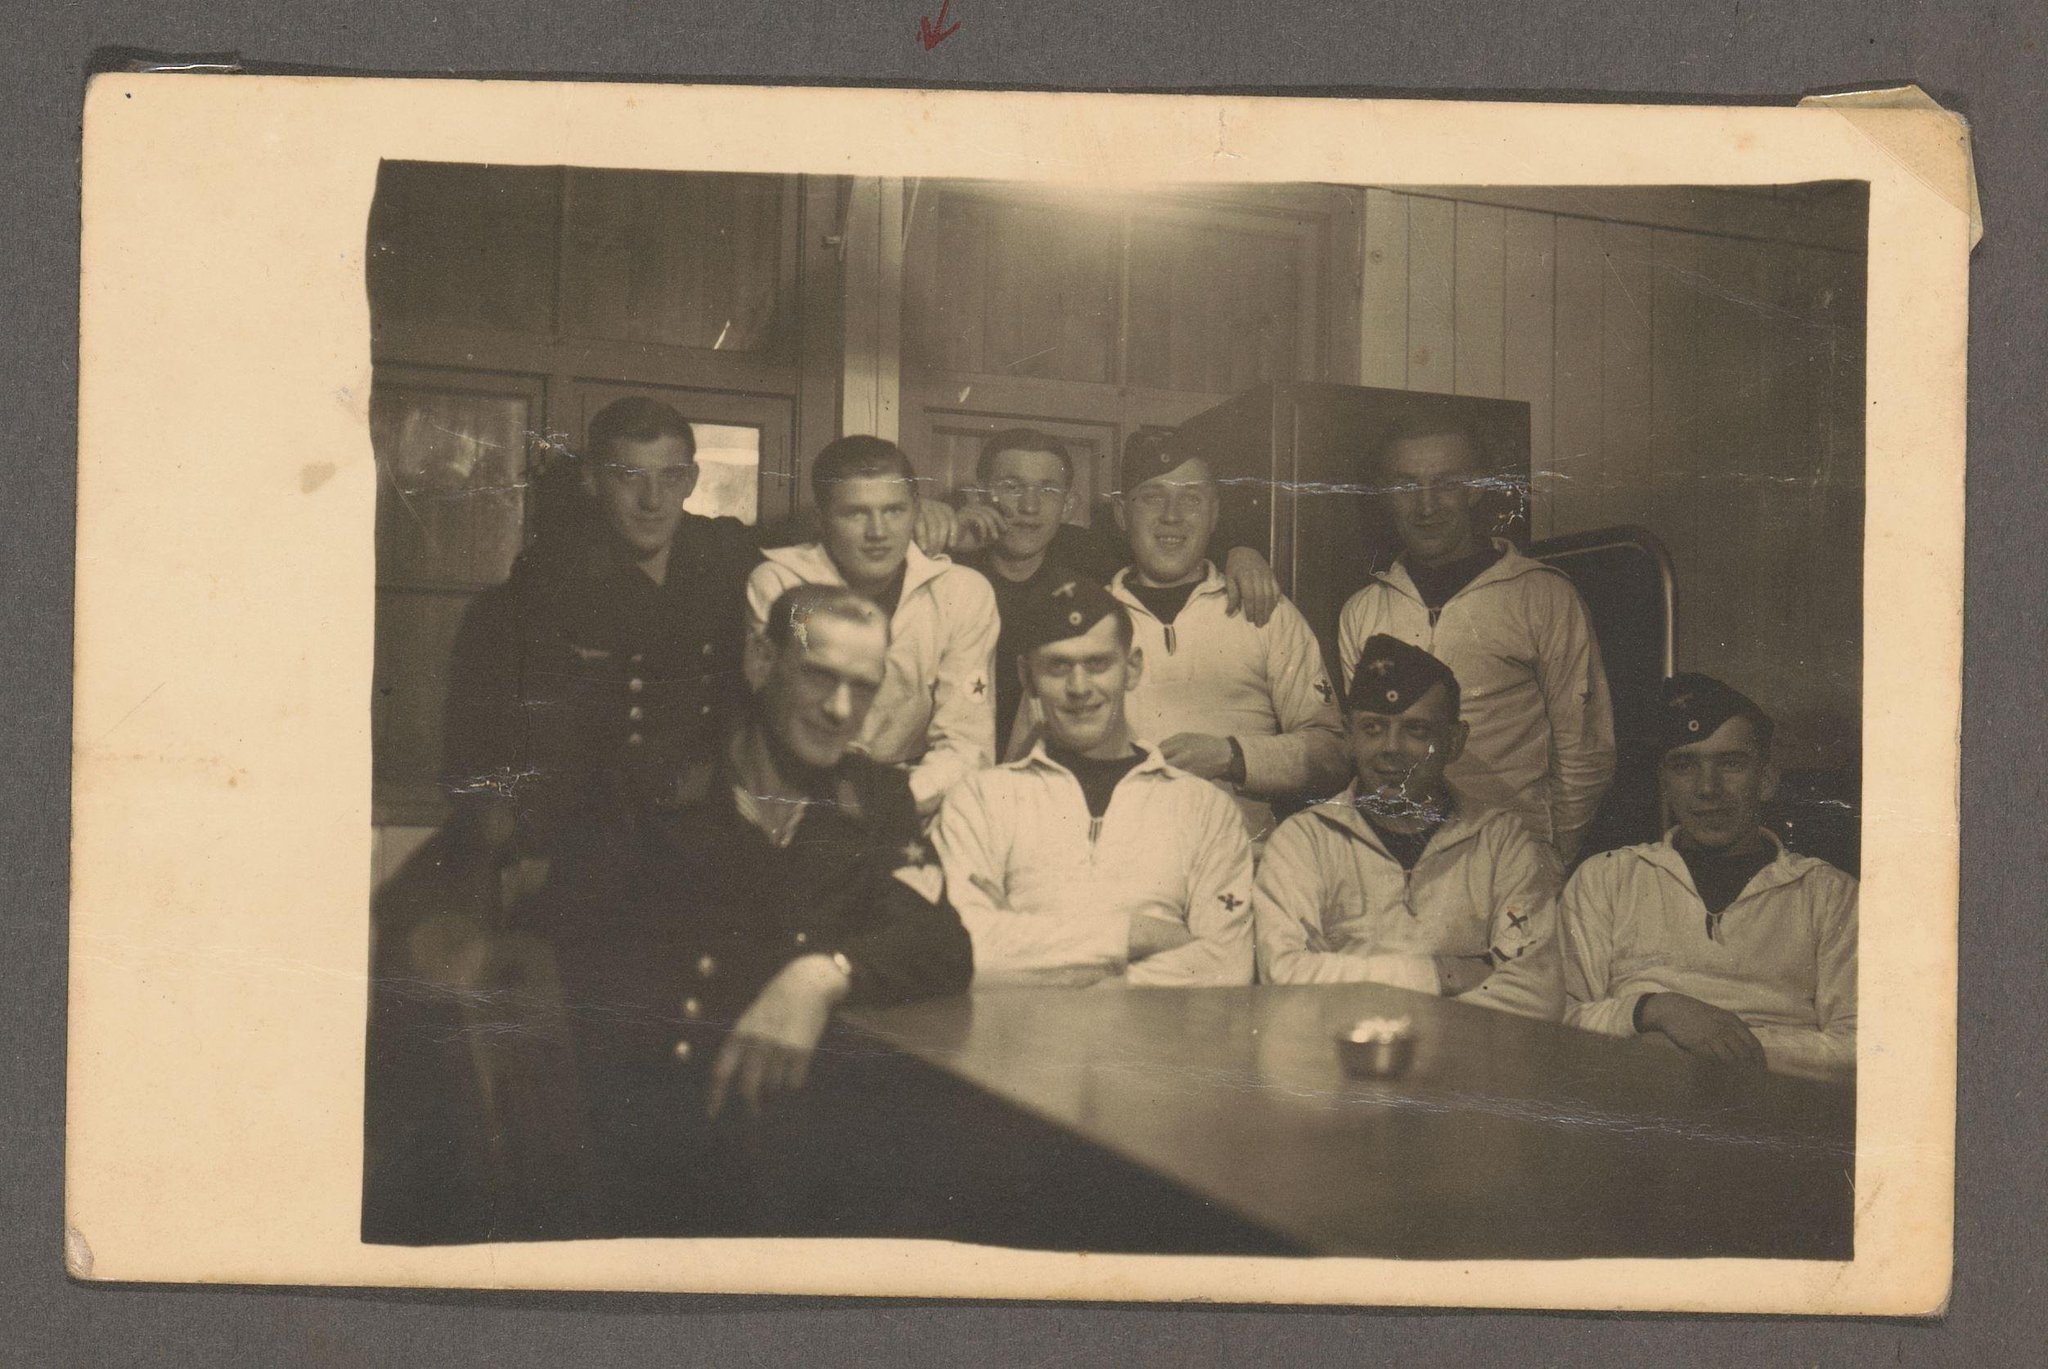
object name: photograph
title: Groep militairen in uniform aan een tafel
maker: Anonymous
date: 1941-1945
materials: paper, photographic support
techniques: gelatin silver print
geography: kiel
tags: the soldier; the soldier's life, (military) uniforms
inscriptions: annotation: ‘Beim 2 A. d. O. in Kiel’